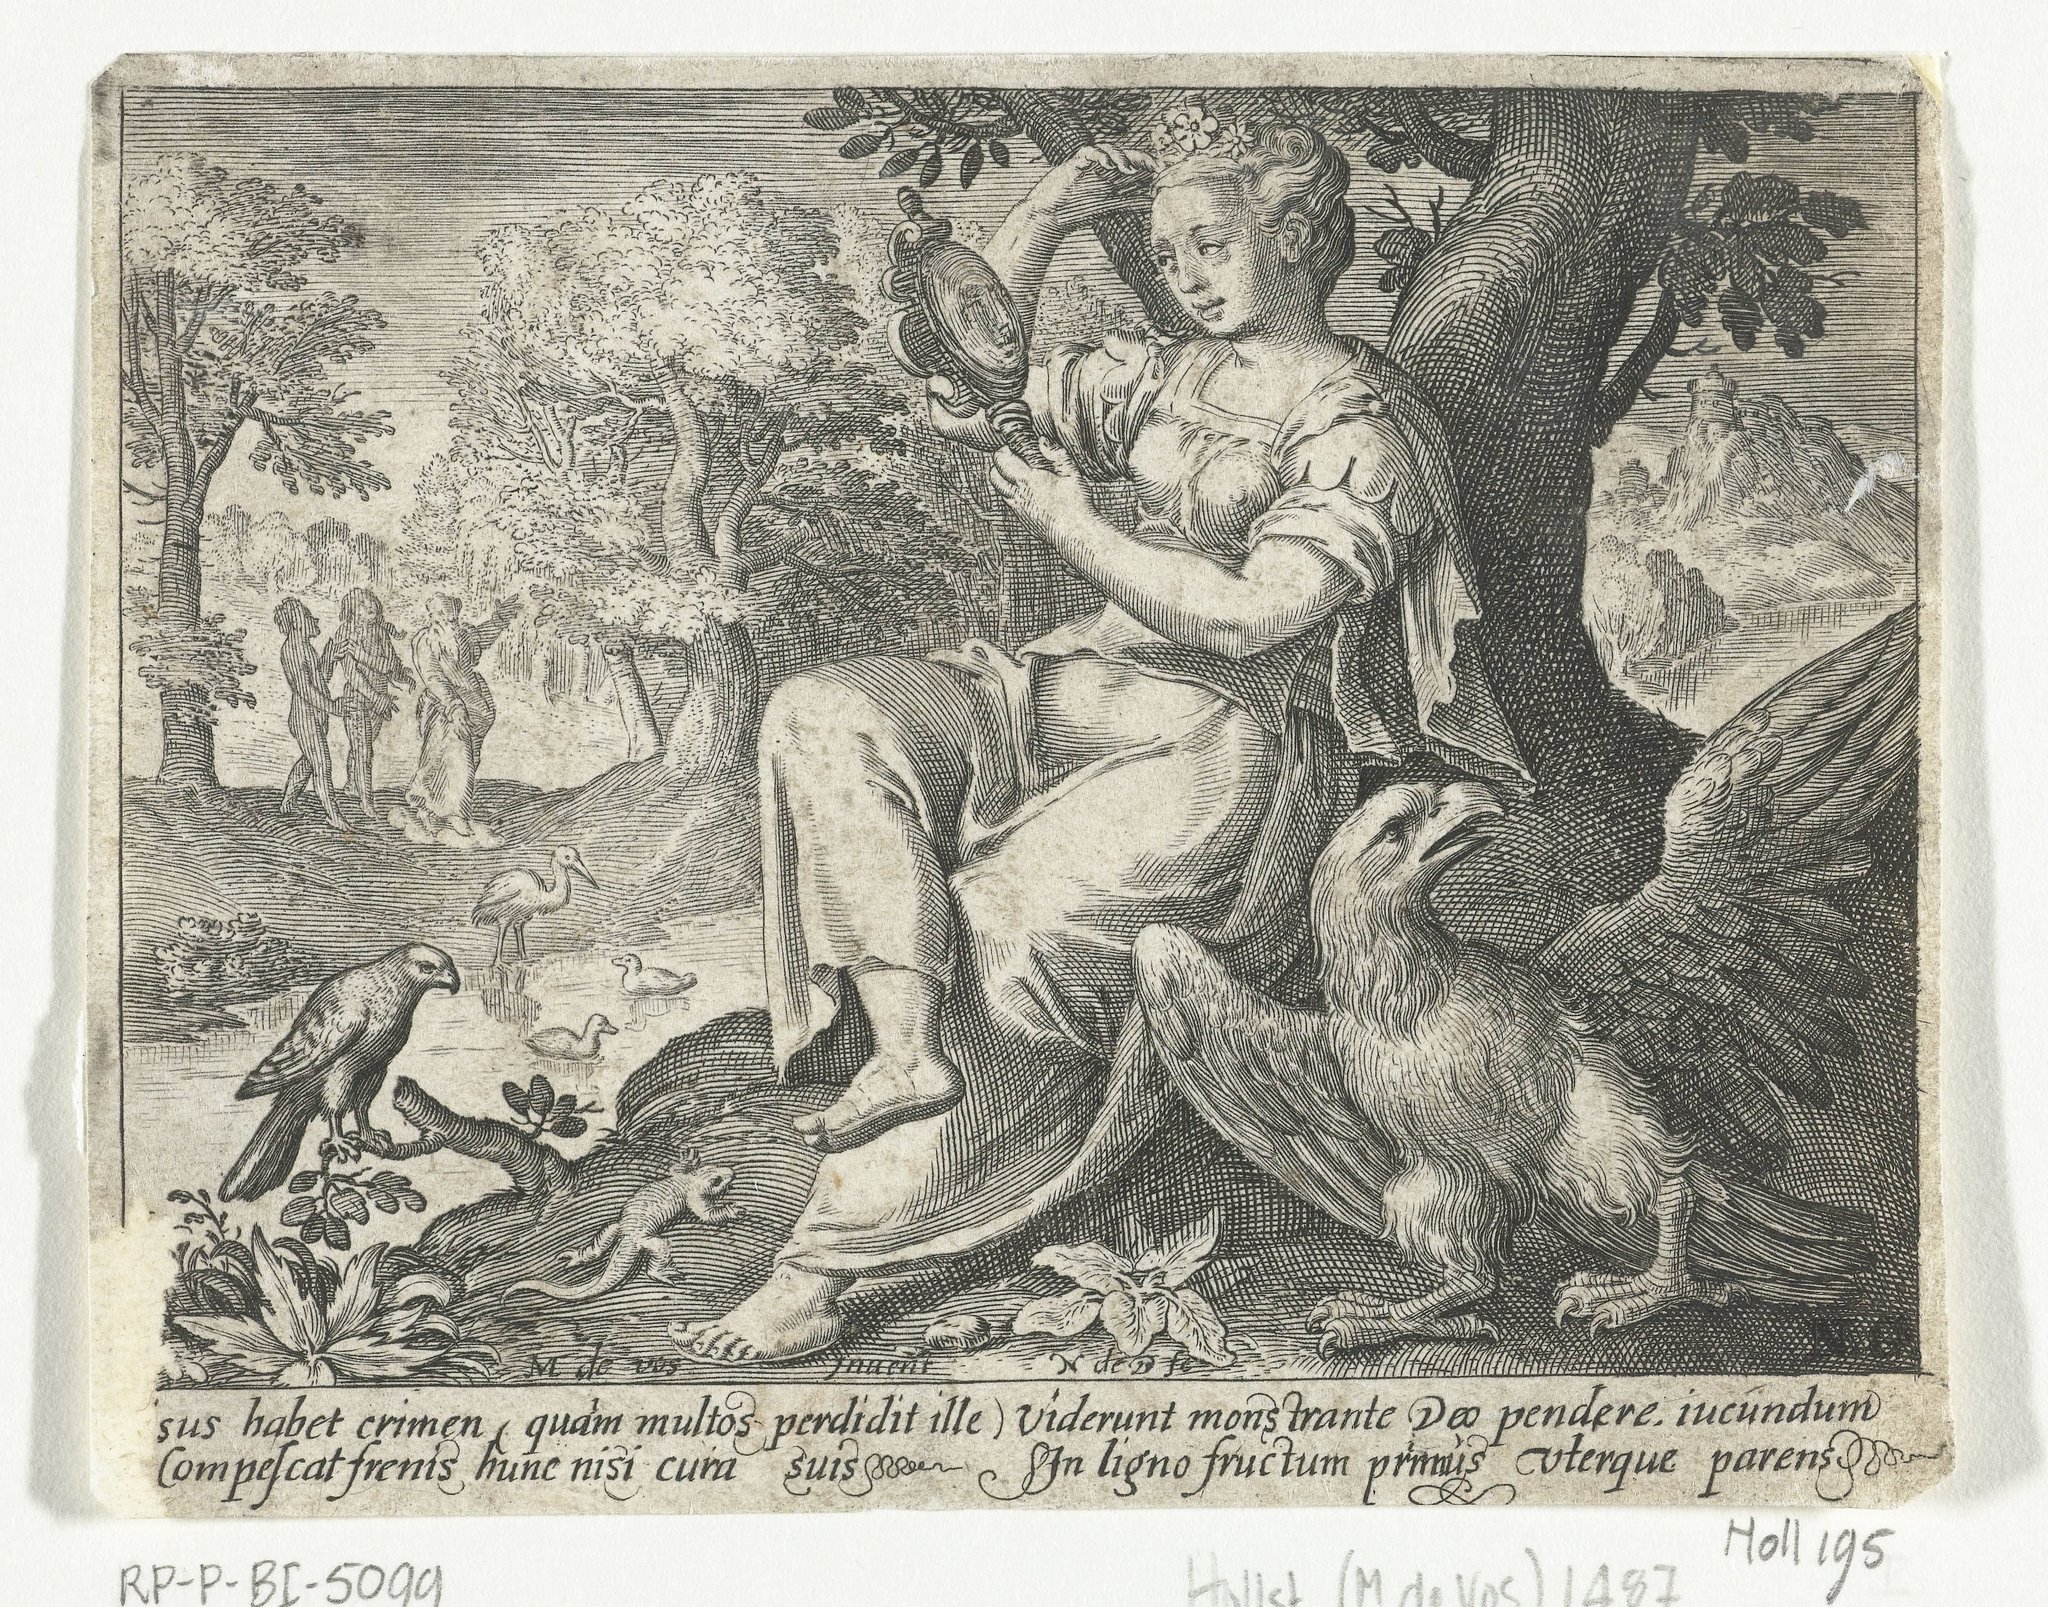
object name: print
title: Zintuig gezicht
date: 1581-1656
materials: paper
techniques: engraving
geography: netherlands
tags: sight, looking (one of the five senses), the giving of the test commandment: god warns adam and eve not to eat from the tree of knowledge of good and evil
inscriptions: collector's mark: Lugt 1967, collector's mark: Lugt 2228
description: Vrouw als personificatie van zintuig gezicht zittend in landschap, zij kijkt in een spiegel terwijl een roofvogel met gespreide vleugels naast haar staat. Op de achtergrond is een scène uit Genesis weergegeven, God toont Adam en Eva de boom der kennis van goed en kwaad. In marge onder twee regels Latijn.